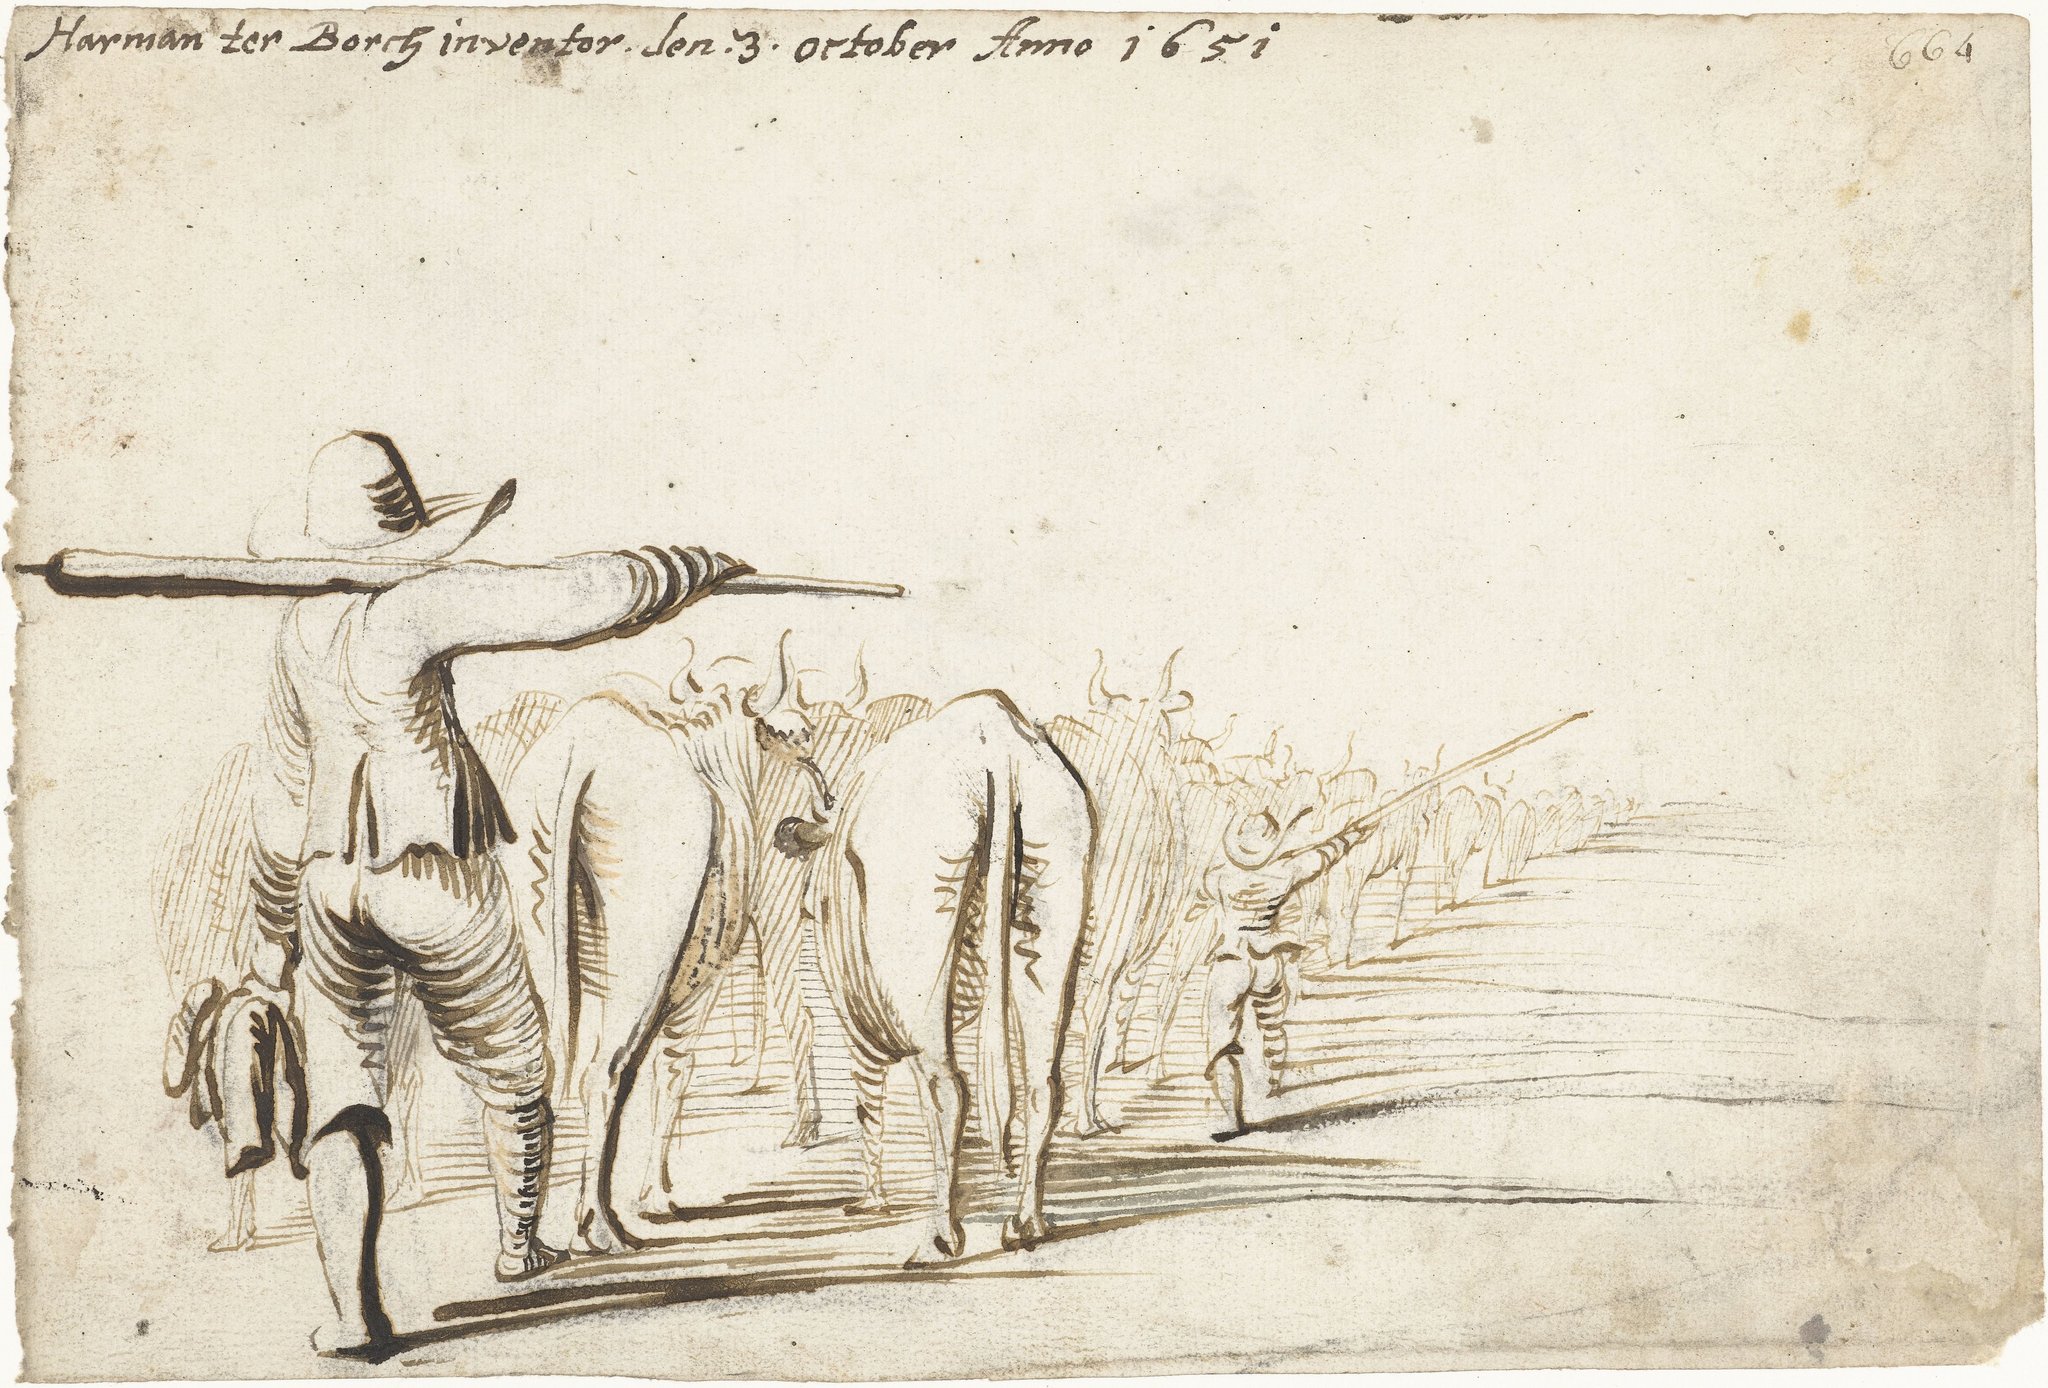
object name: drawing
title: Twee koeienhouders drijven hun vee, van achteren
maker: harmen ter borch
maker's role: draughtsman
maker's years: 1638-1677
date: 1651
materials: chalk, ink, paper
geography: zwolle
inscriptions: annotation: ‘A C’, annotation: ‘Harman ter Borch inventor. den.3.October Anno 1651’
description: Twee koeienhouders drijven hun vee, van achteren. Op verso een schetsje van een gezicht.